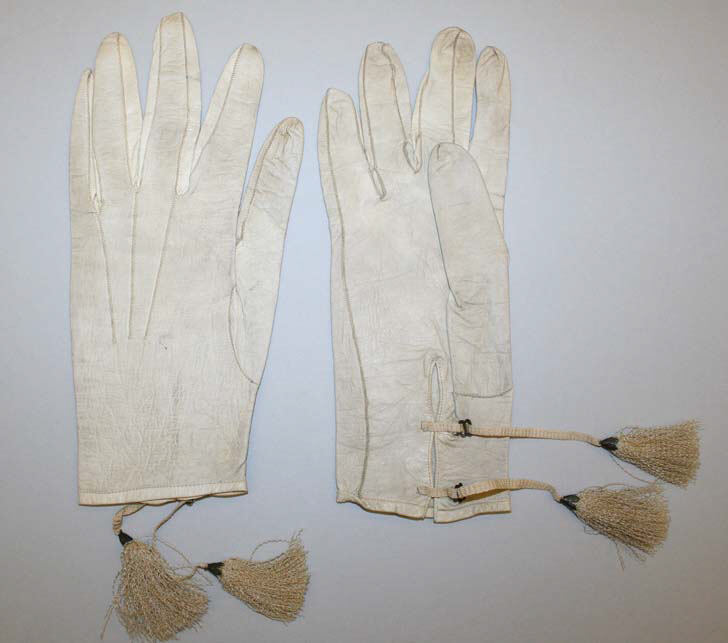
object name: glove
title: Gloves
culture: european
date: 1870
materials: leather